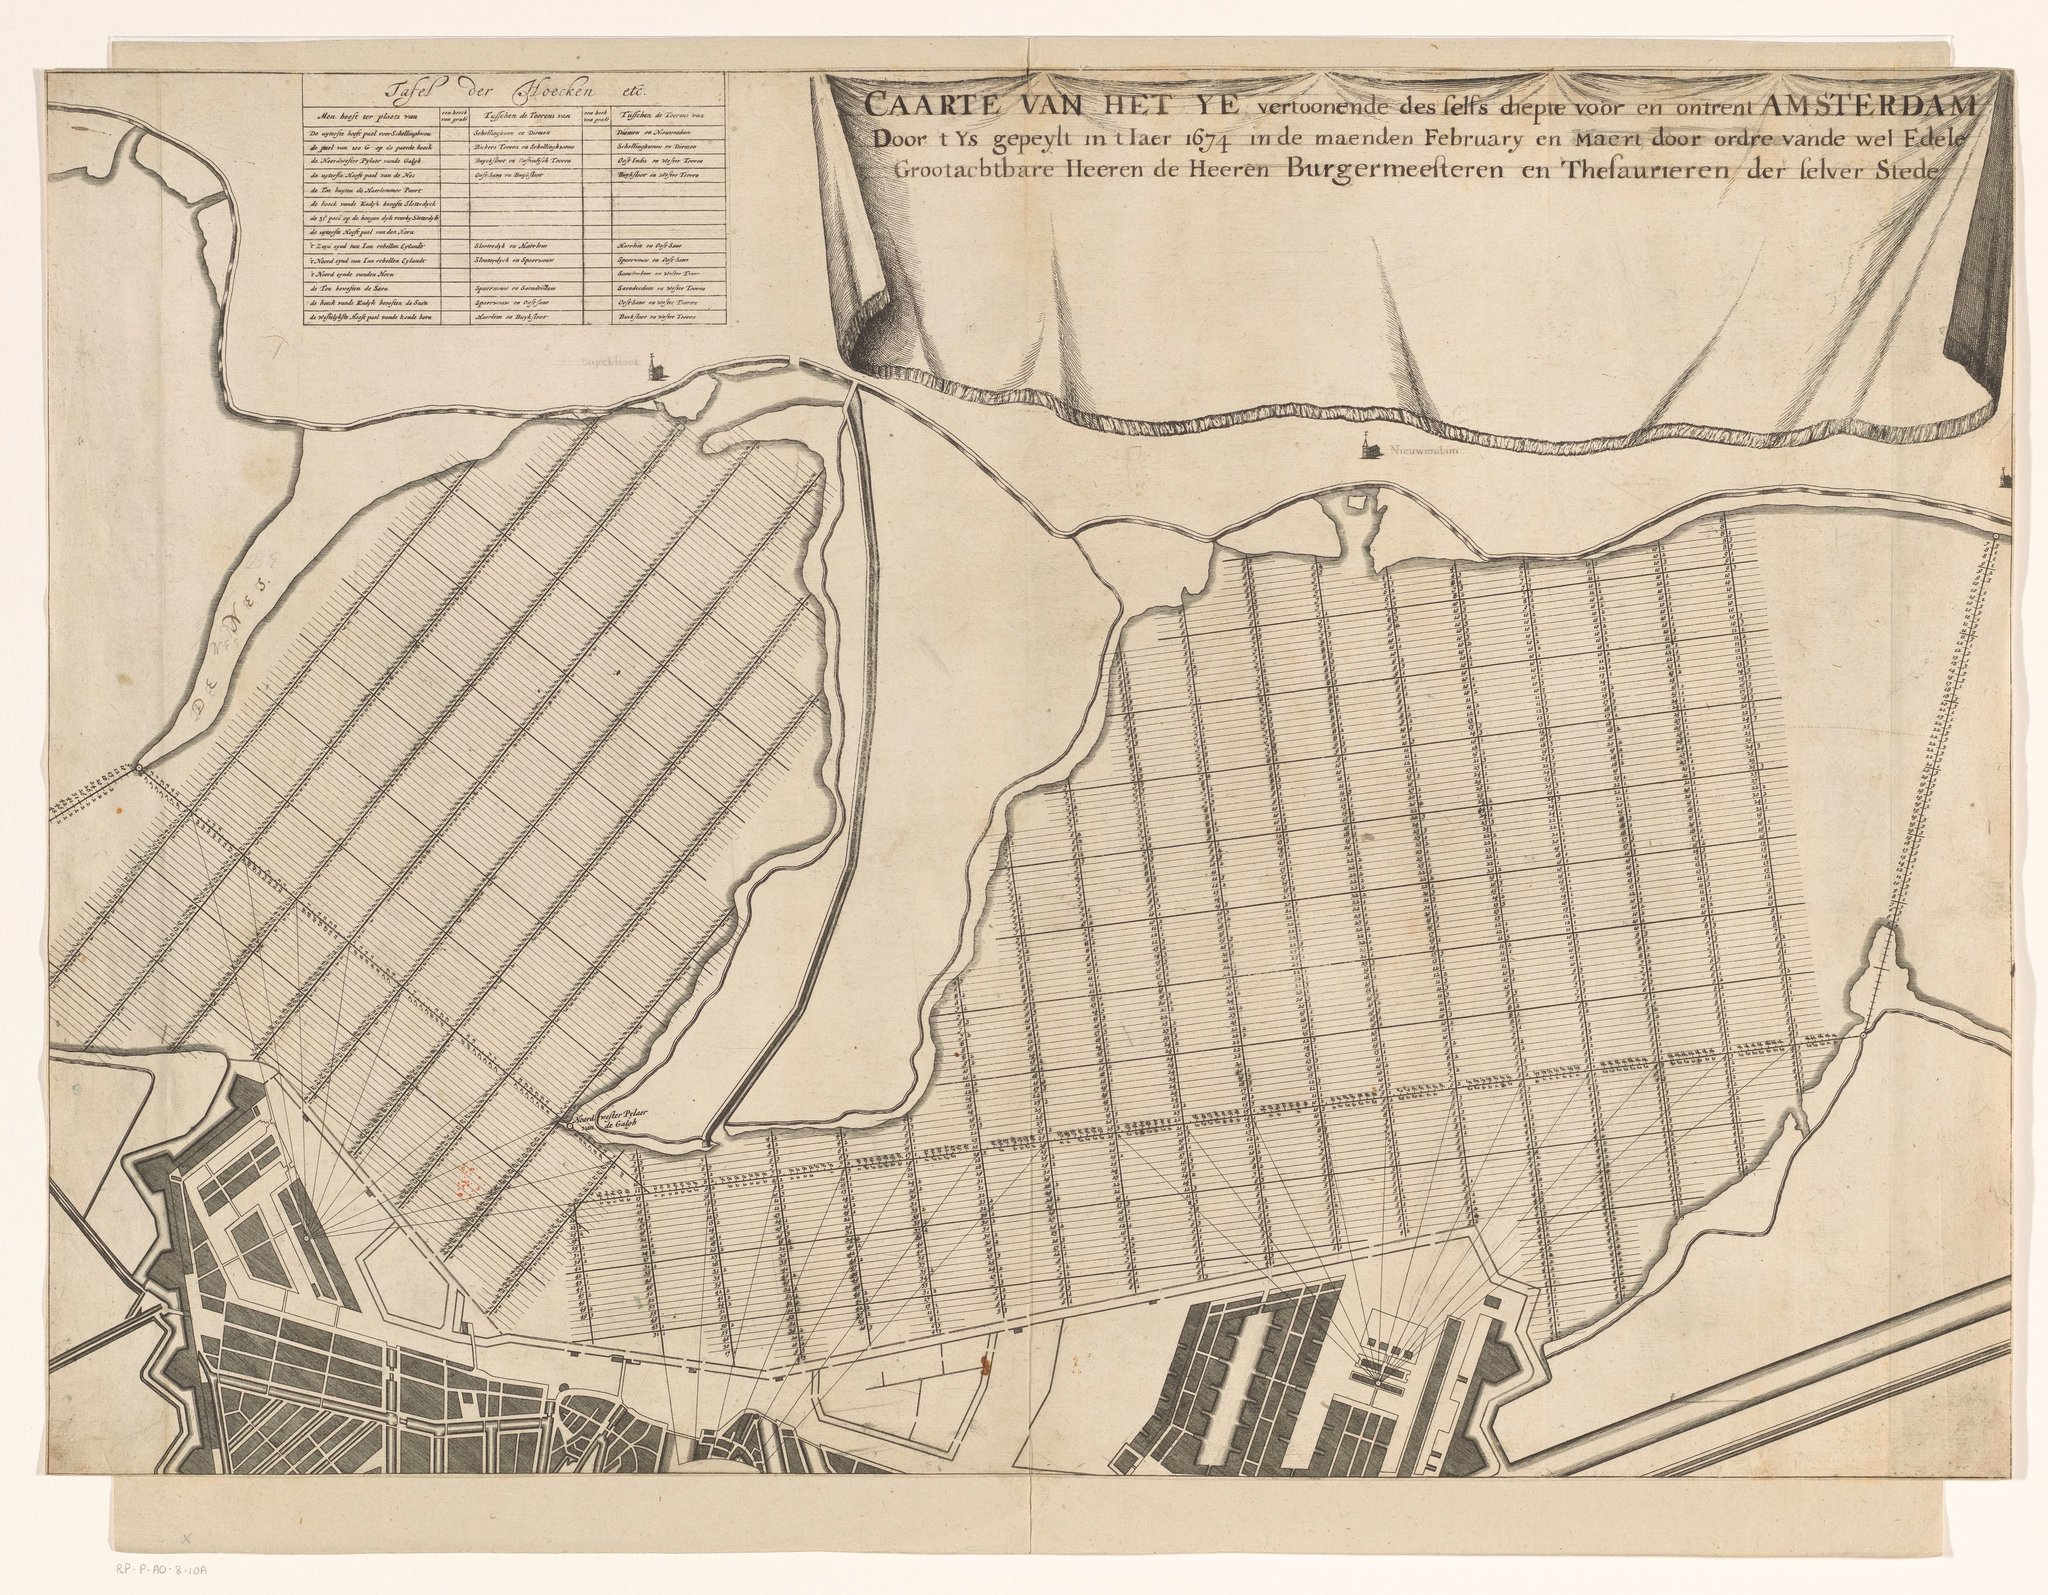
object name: print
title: Caarte van het Ye; vertoonende des selfs diepte voor en ontrent Amsterdam door 't ys gepeylt in 't iaer 1674 in de maenden february en maert, door ordre vande wel edele grootachtbare heeren de heeren burgermeesteren en thesaurieren der selver stede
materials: ink, paper, pencil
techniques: engraving, etching, pen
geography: amsterdam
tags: maps of separate countries or regions, river, maps of cities, amsterdam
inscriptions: collector's mark: Lugt 195, inscription: ‘Caarte van het Ye; vertoonende des selfs diepte voor en ontrent Amsterdam door 't ys gepeylt in 't iaer 1674 in de maenden february en maert, door ordre vande wel edele grootachtbare heeren de heeren burgermeesteren en thesaurieren der selver stede’, inscription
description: Dit is een proefdruk; de titel is handgeschreven, net als 'De Nes'. Verder ontbreken nog details en stukken tekst die wel te zien zijn op een latere staat (zelfde titel maar dan gedrukt, een exemplaar in het bezit van de Universiteit Utrecht).